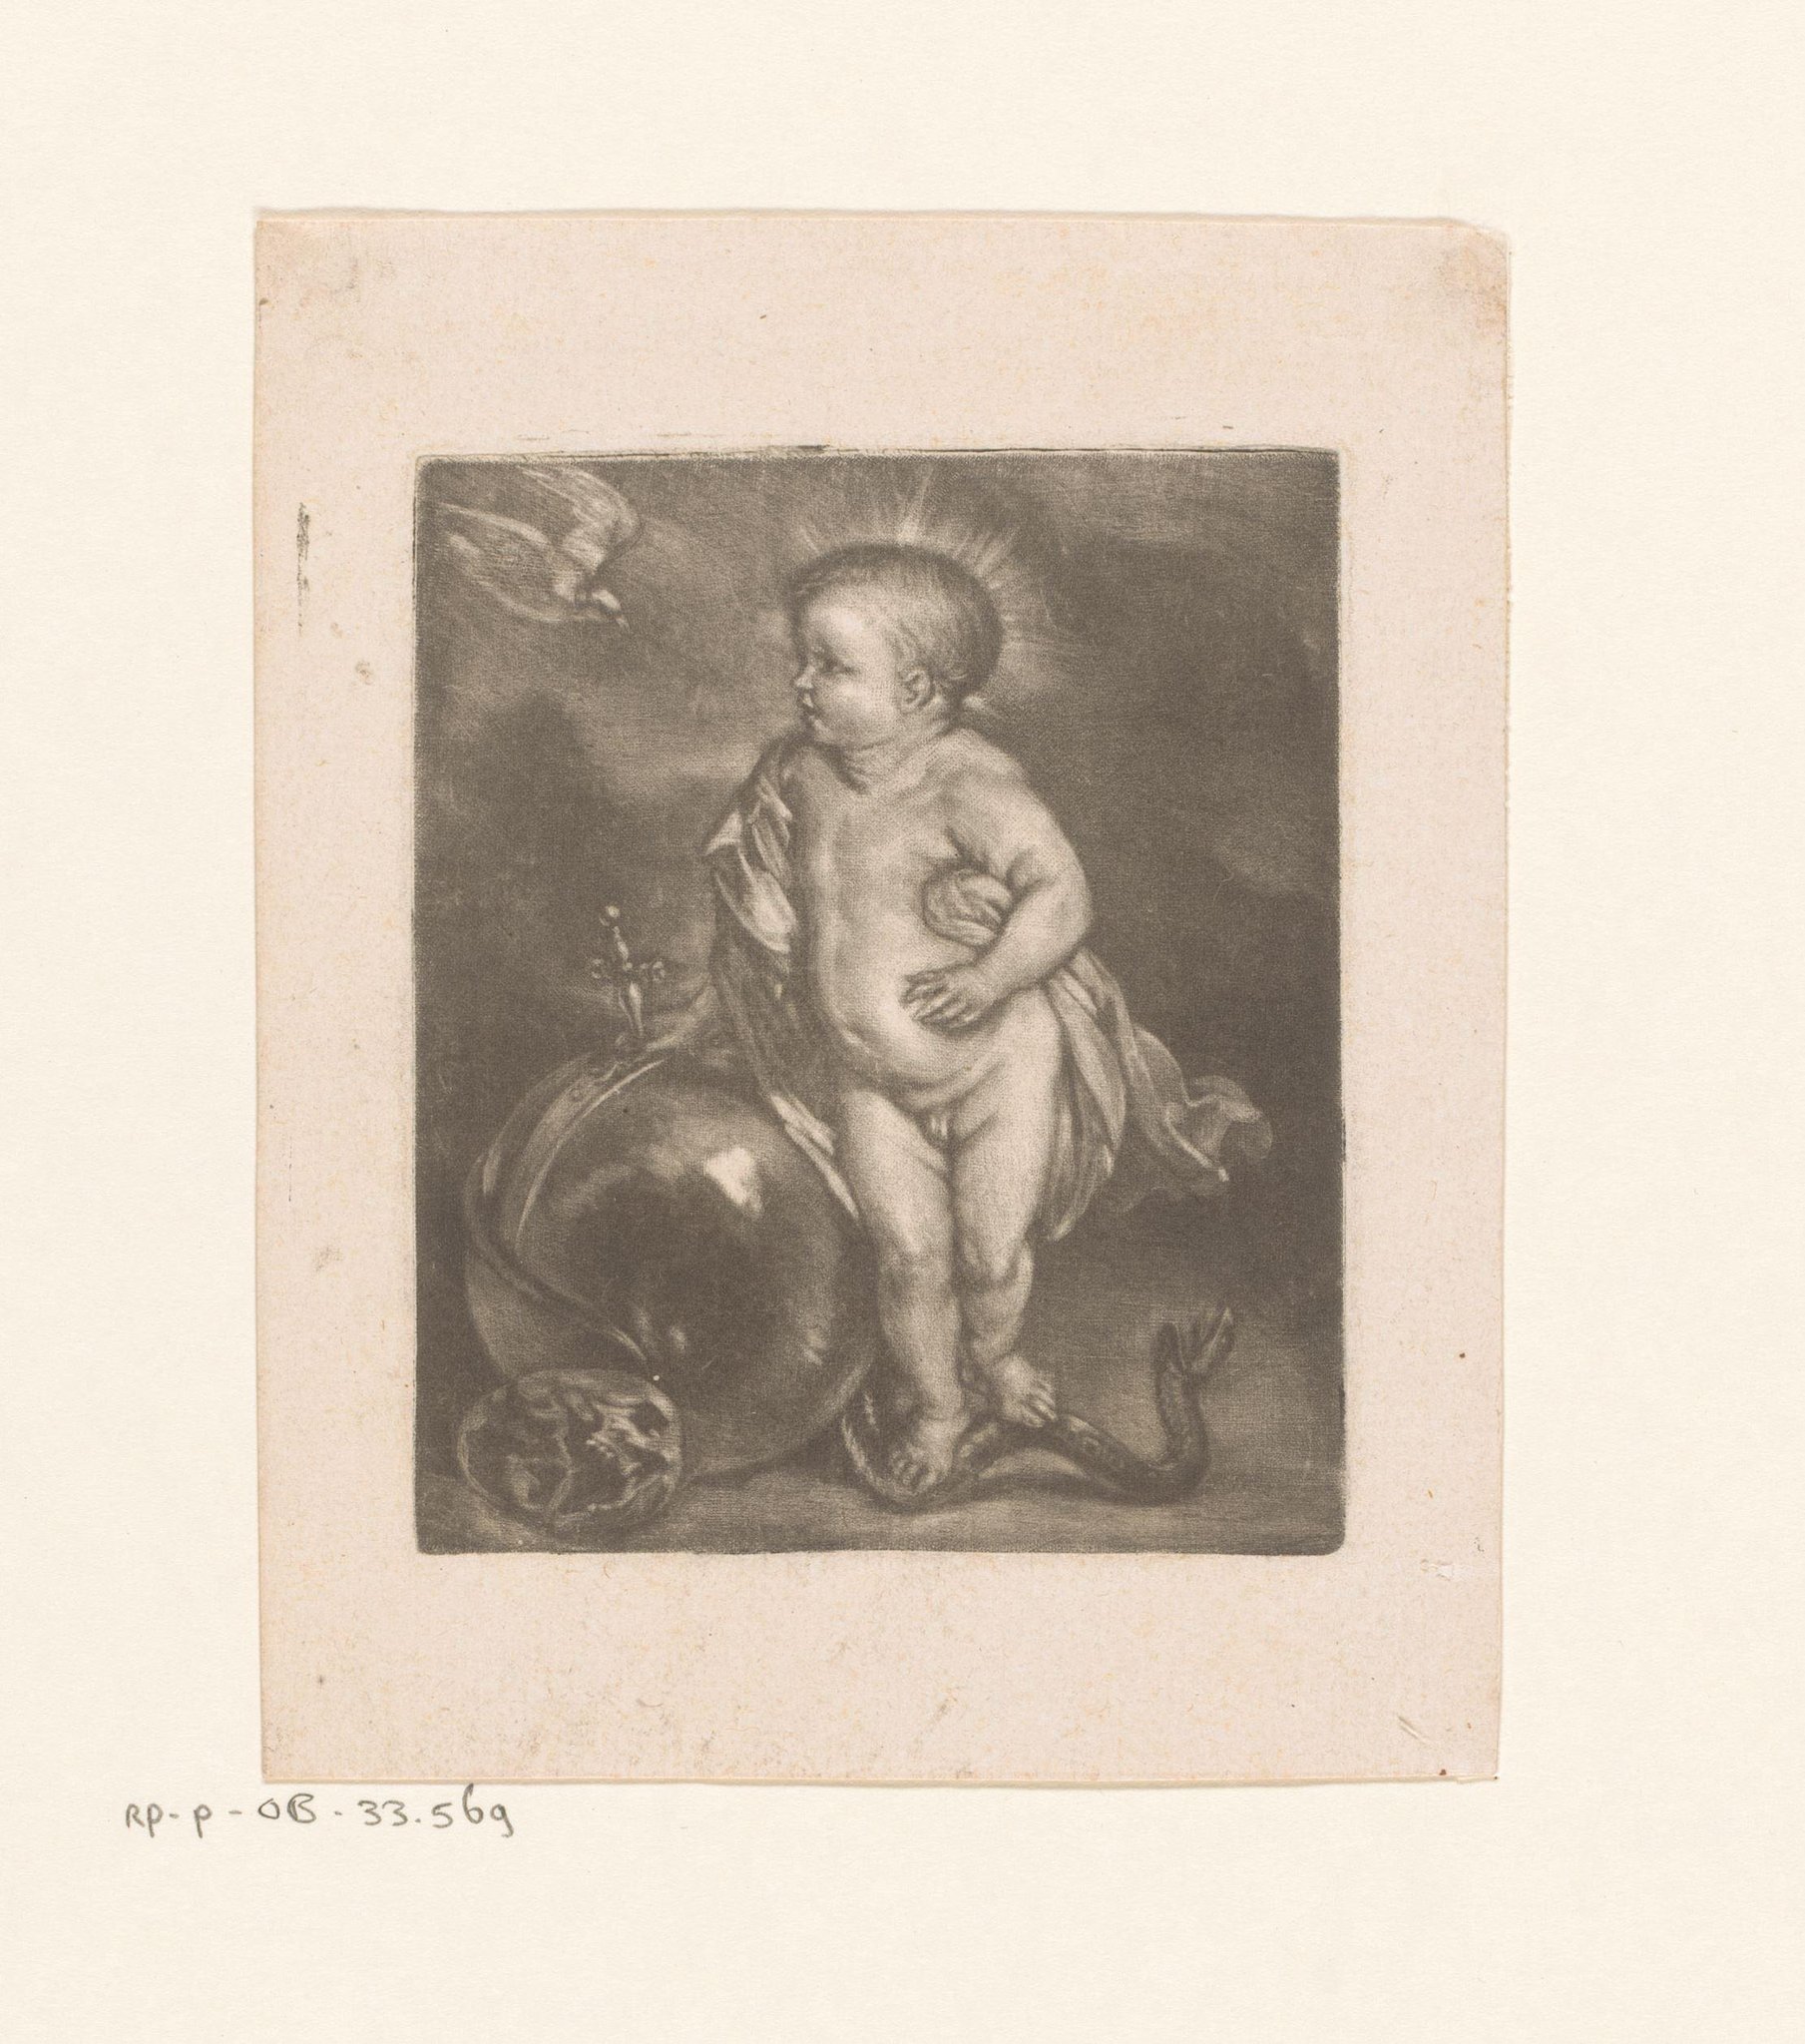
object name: print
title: Christuskind als Salvator Mundi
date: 1680-1700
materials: paper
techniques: mezzotint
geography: england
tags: christ-child ~ types of adult christ, 'salvator mundi', making a blessing gesture; an orb in his hand or at his feet - dd - christ beardless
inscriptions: collector's mark: Lugt 240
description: Christus kijkt links naar een duif. Hij leunt op een rijksappel en vertrapt een slang. Links ligt een schedel.